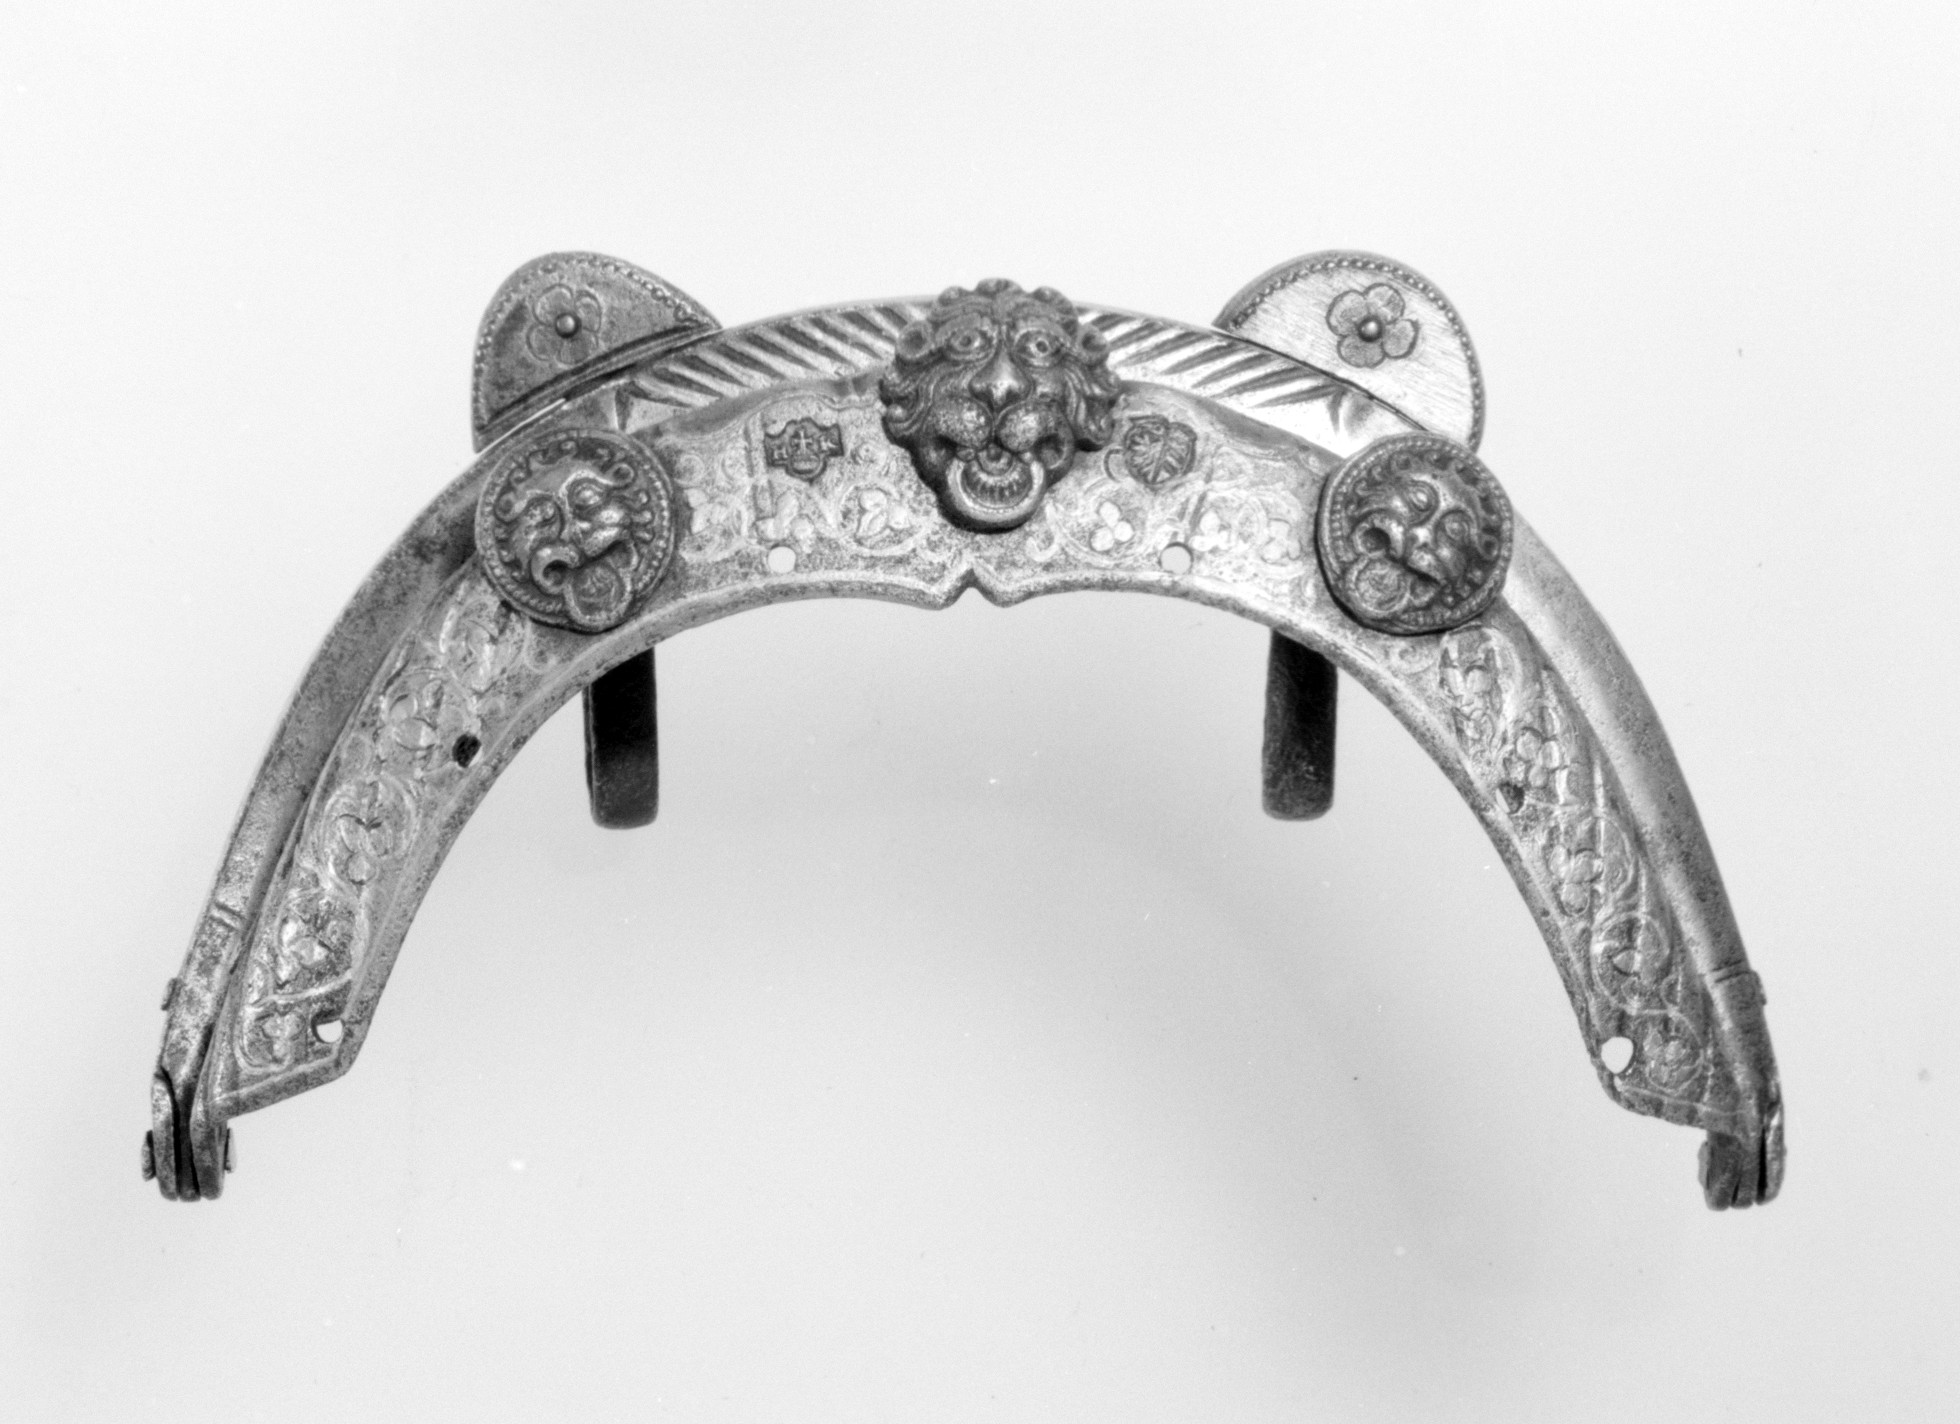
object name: purse frame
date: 1501-1600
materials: steel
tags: lions